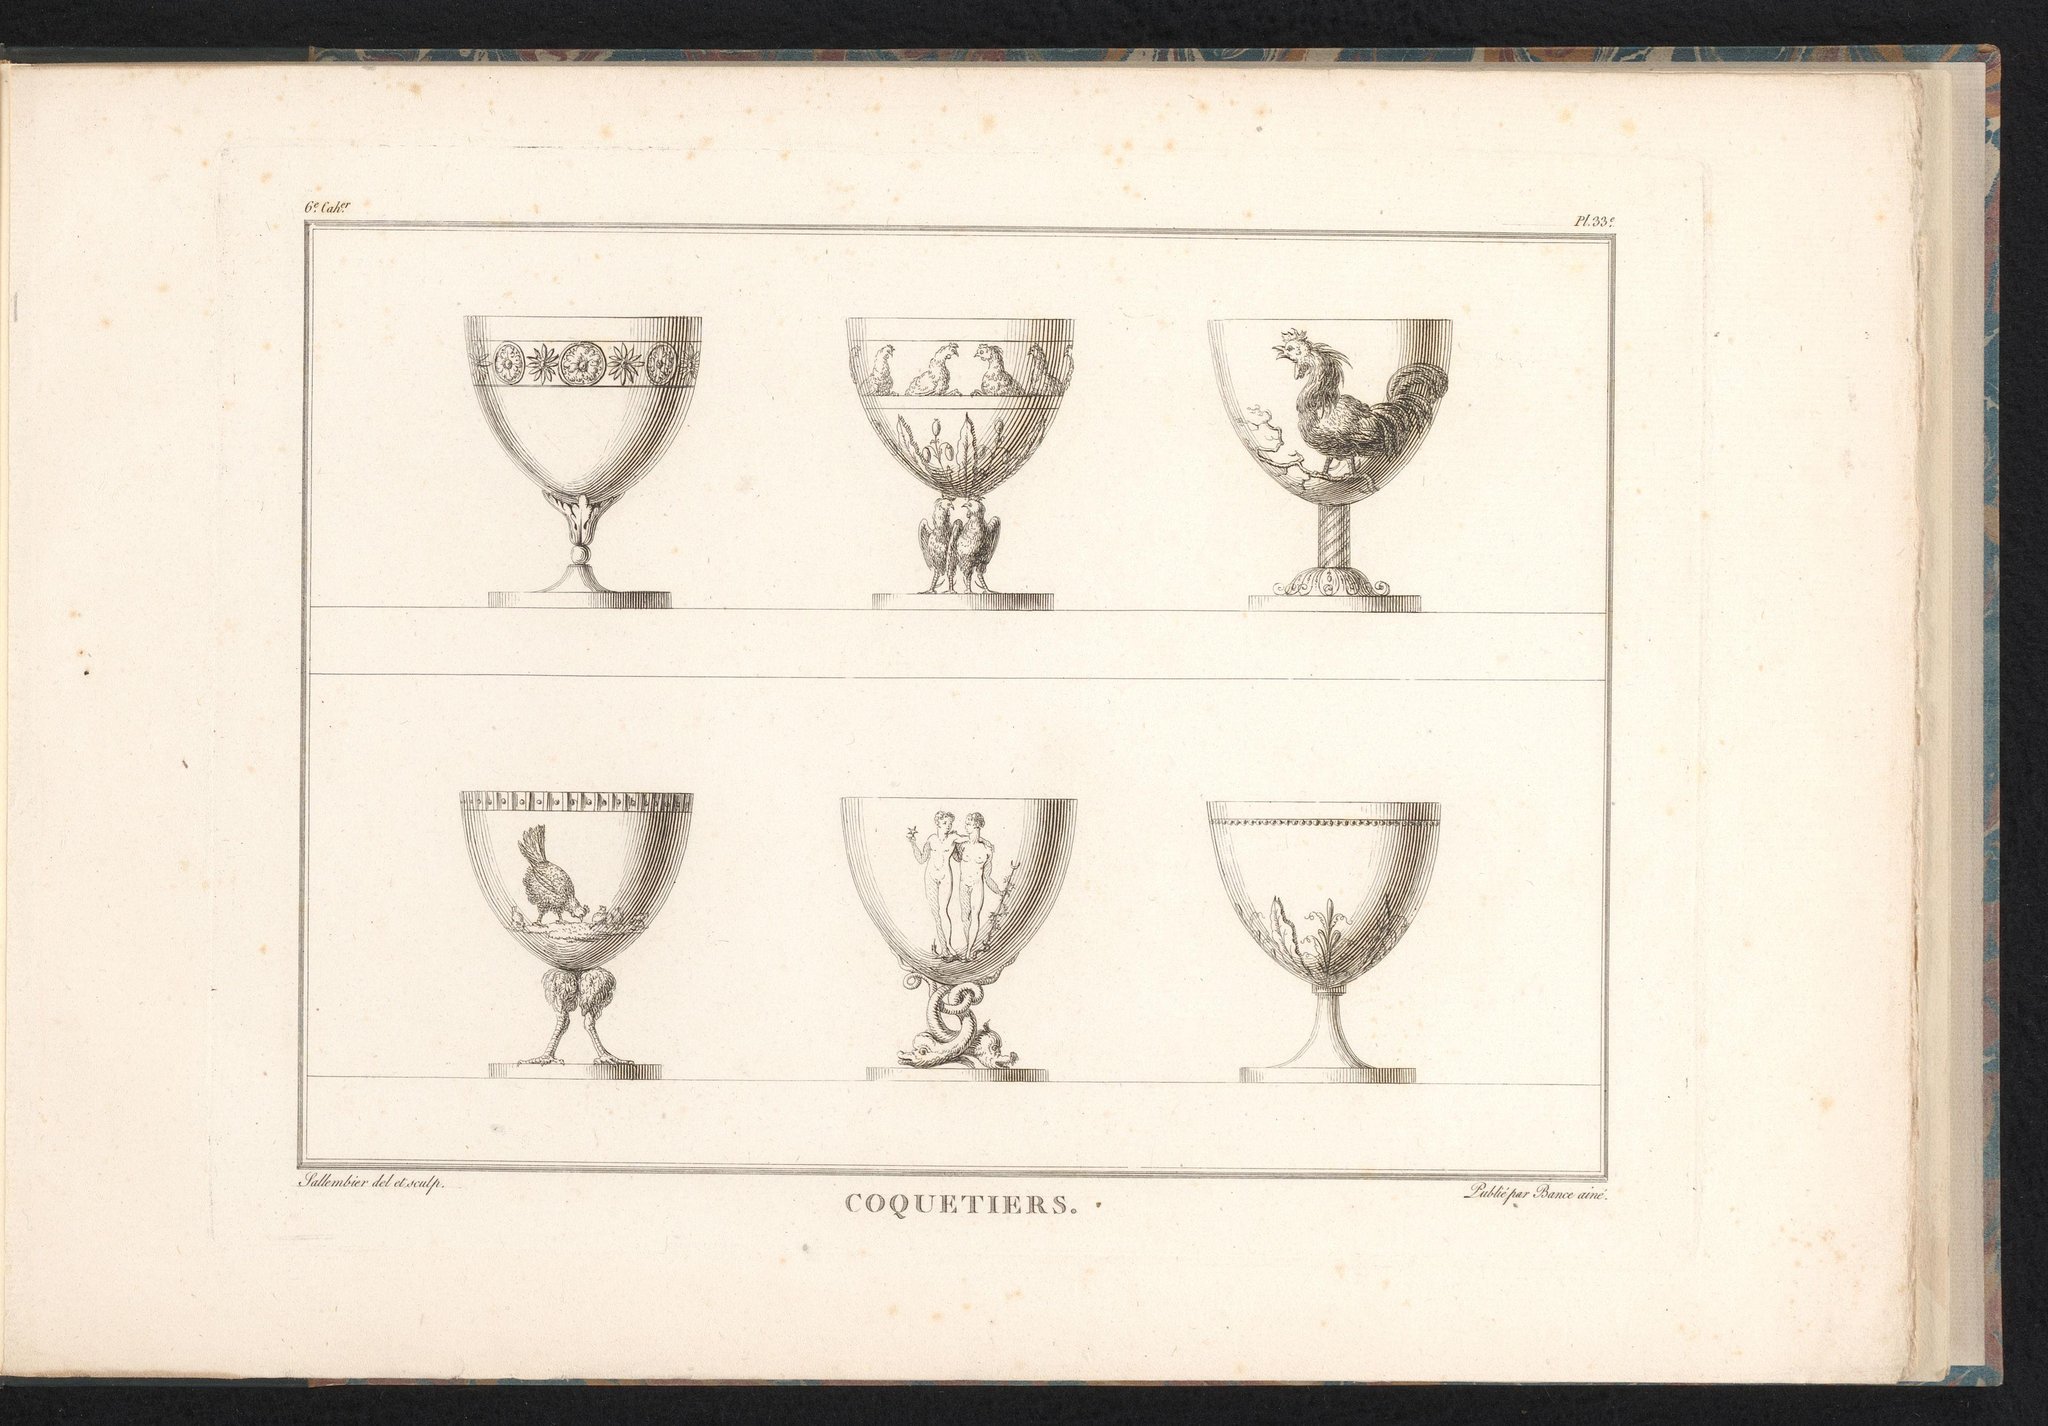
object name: print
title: Eierdoppen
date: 1805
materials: paper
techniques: etching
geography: paris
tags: egg-cup, fowl (cock, hen, chicken, etc.)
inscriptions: number: ‘6.e Cah.er’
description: Ontwerpen voor zes eierdoppen met decoratie van kippen en een haan. Prent maakt deel uit van een album.